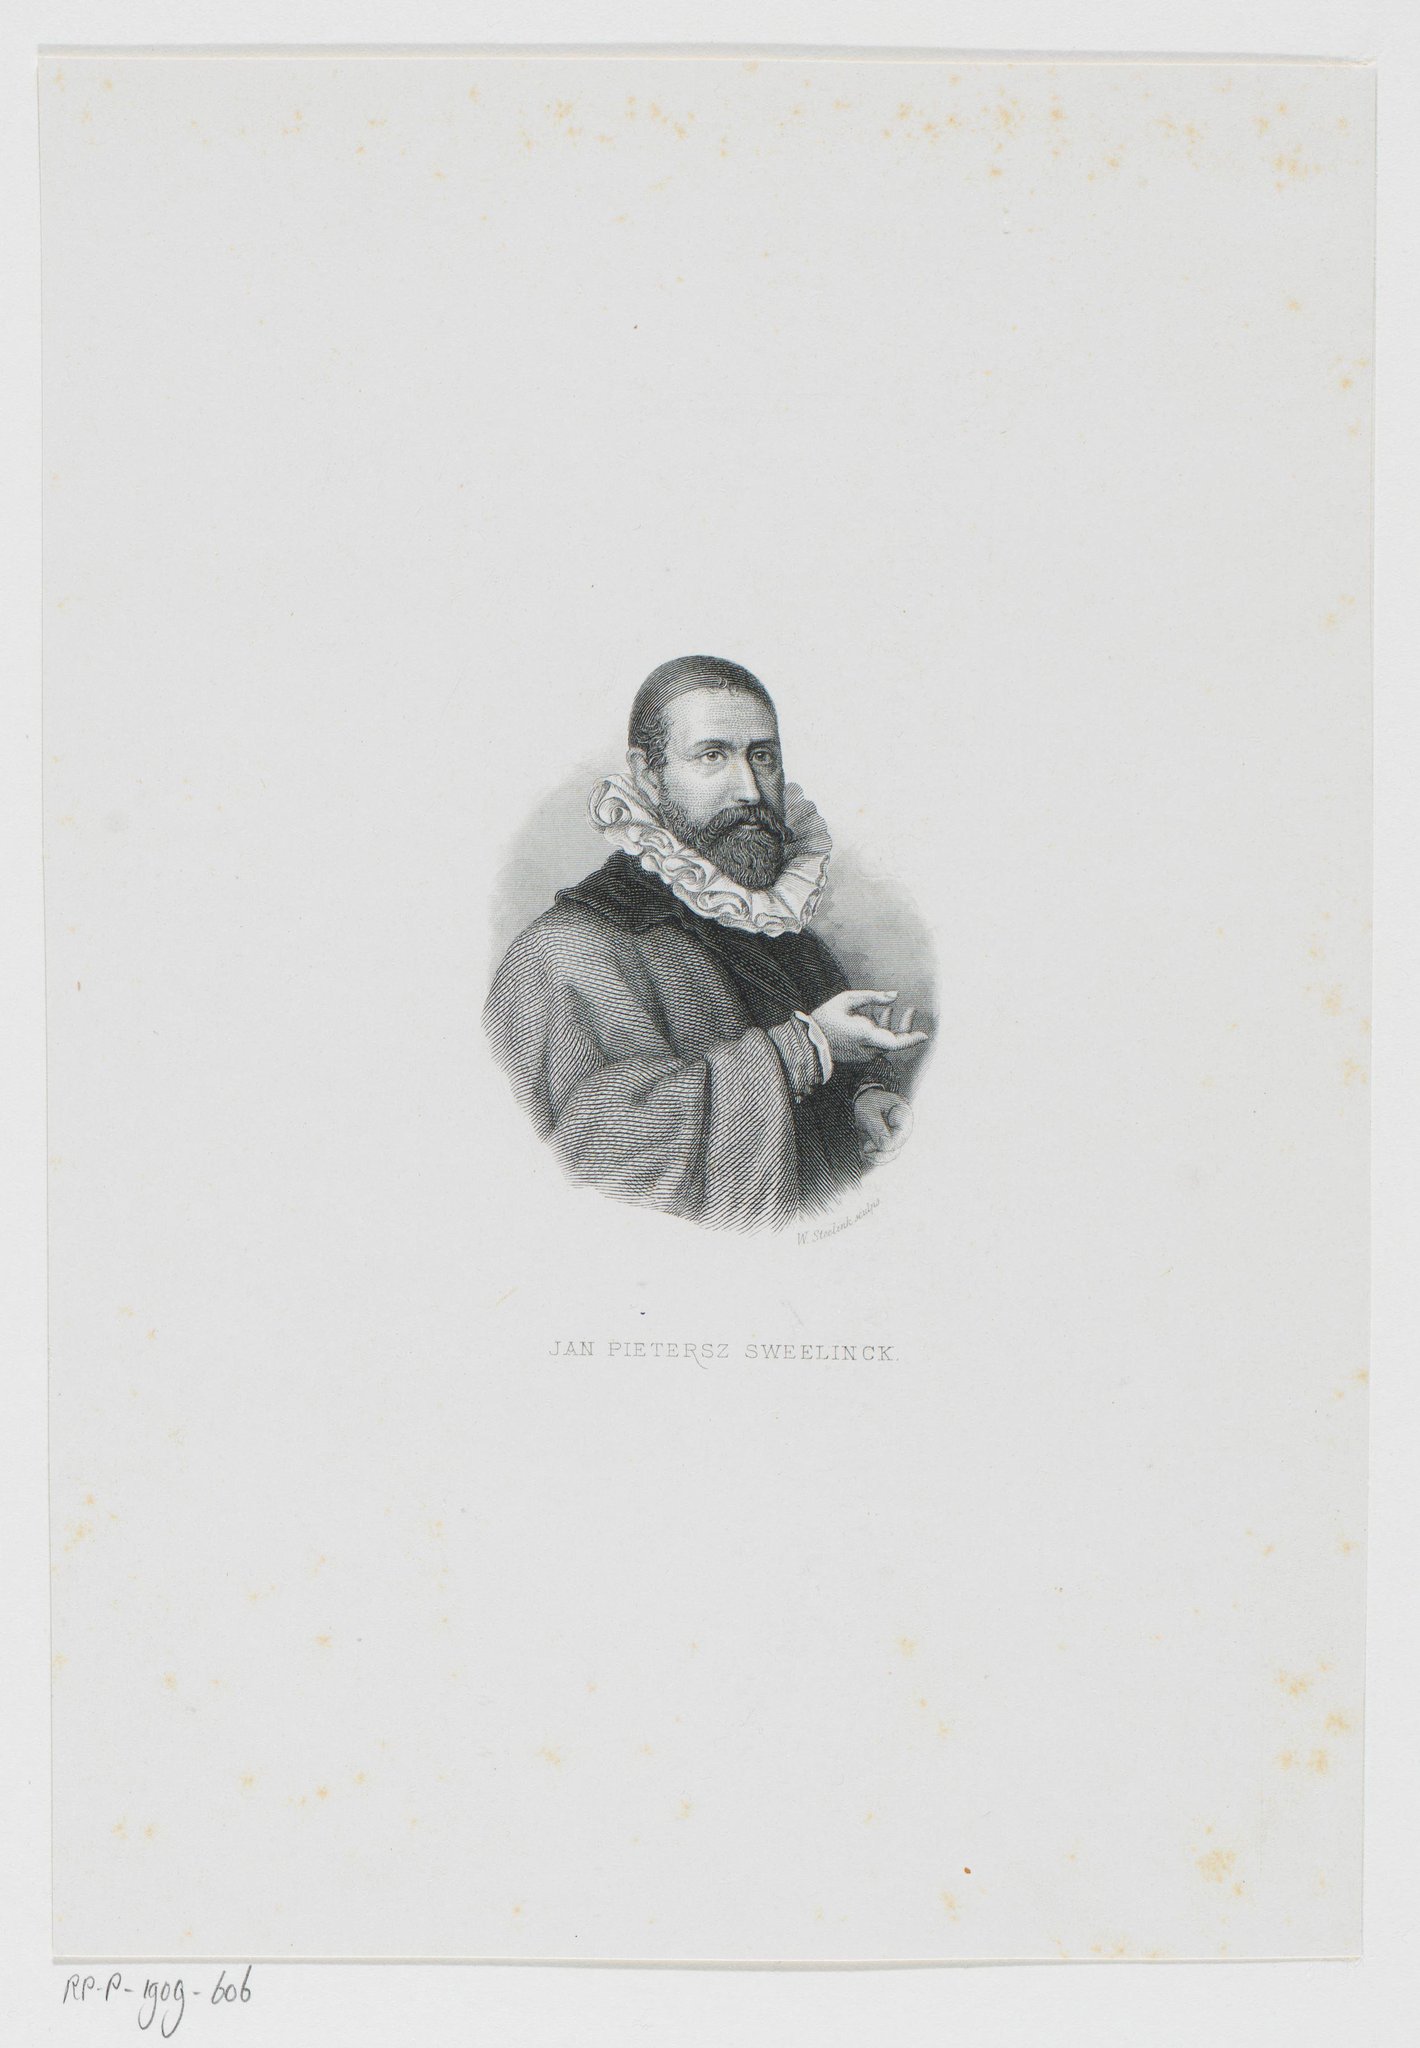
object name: print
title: Portret van Jan Pieterszoon Sweelinck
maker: willem steelink (i)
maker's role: draughtsman, print maker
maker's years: 1826-1913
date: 1836-1909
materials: paper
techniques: engraving, etching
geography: amsterdam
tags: deventer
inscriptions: collector's mark: Lugt 2228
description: Portret van Jan Pieterszoon Sweelinck, componist en organist.